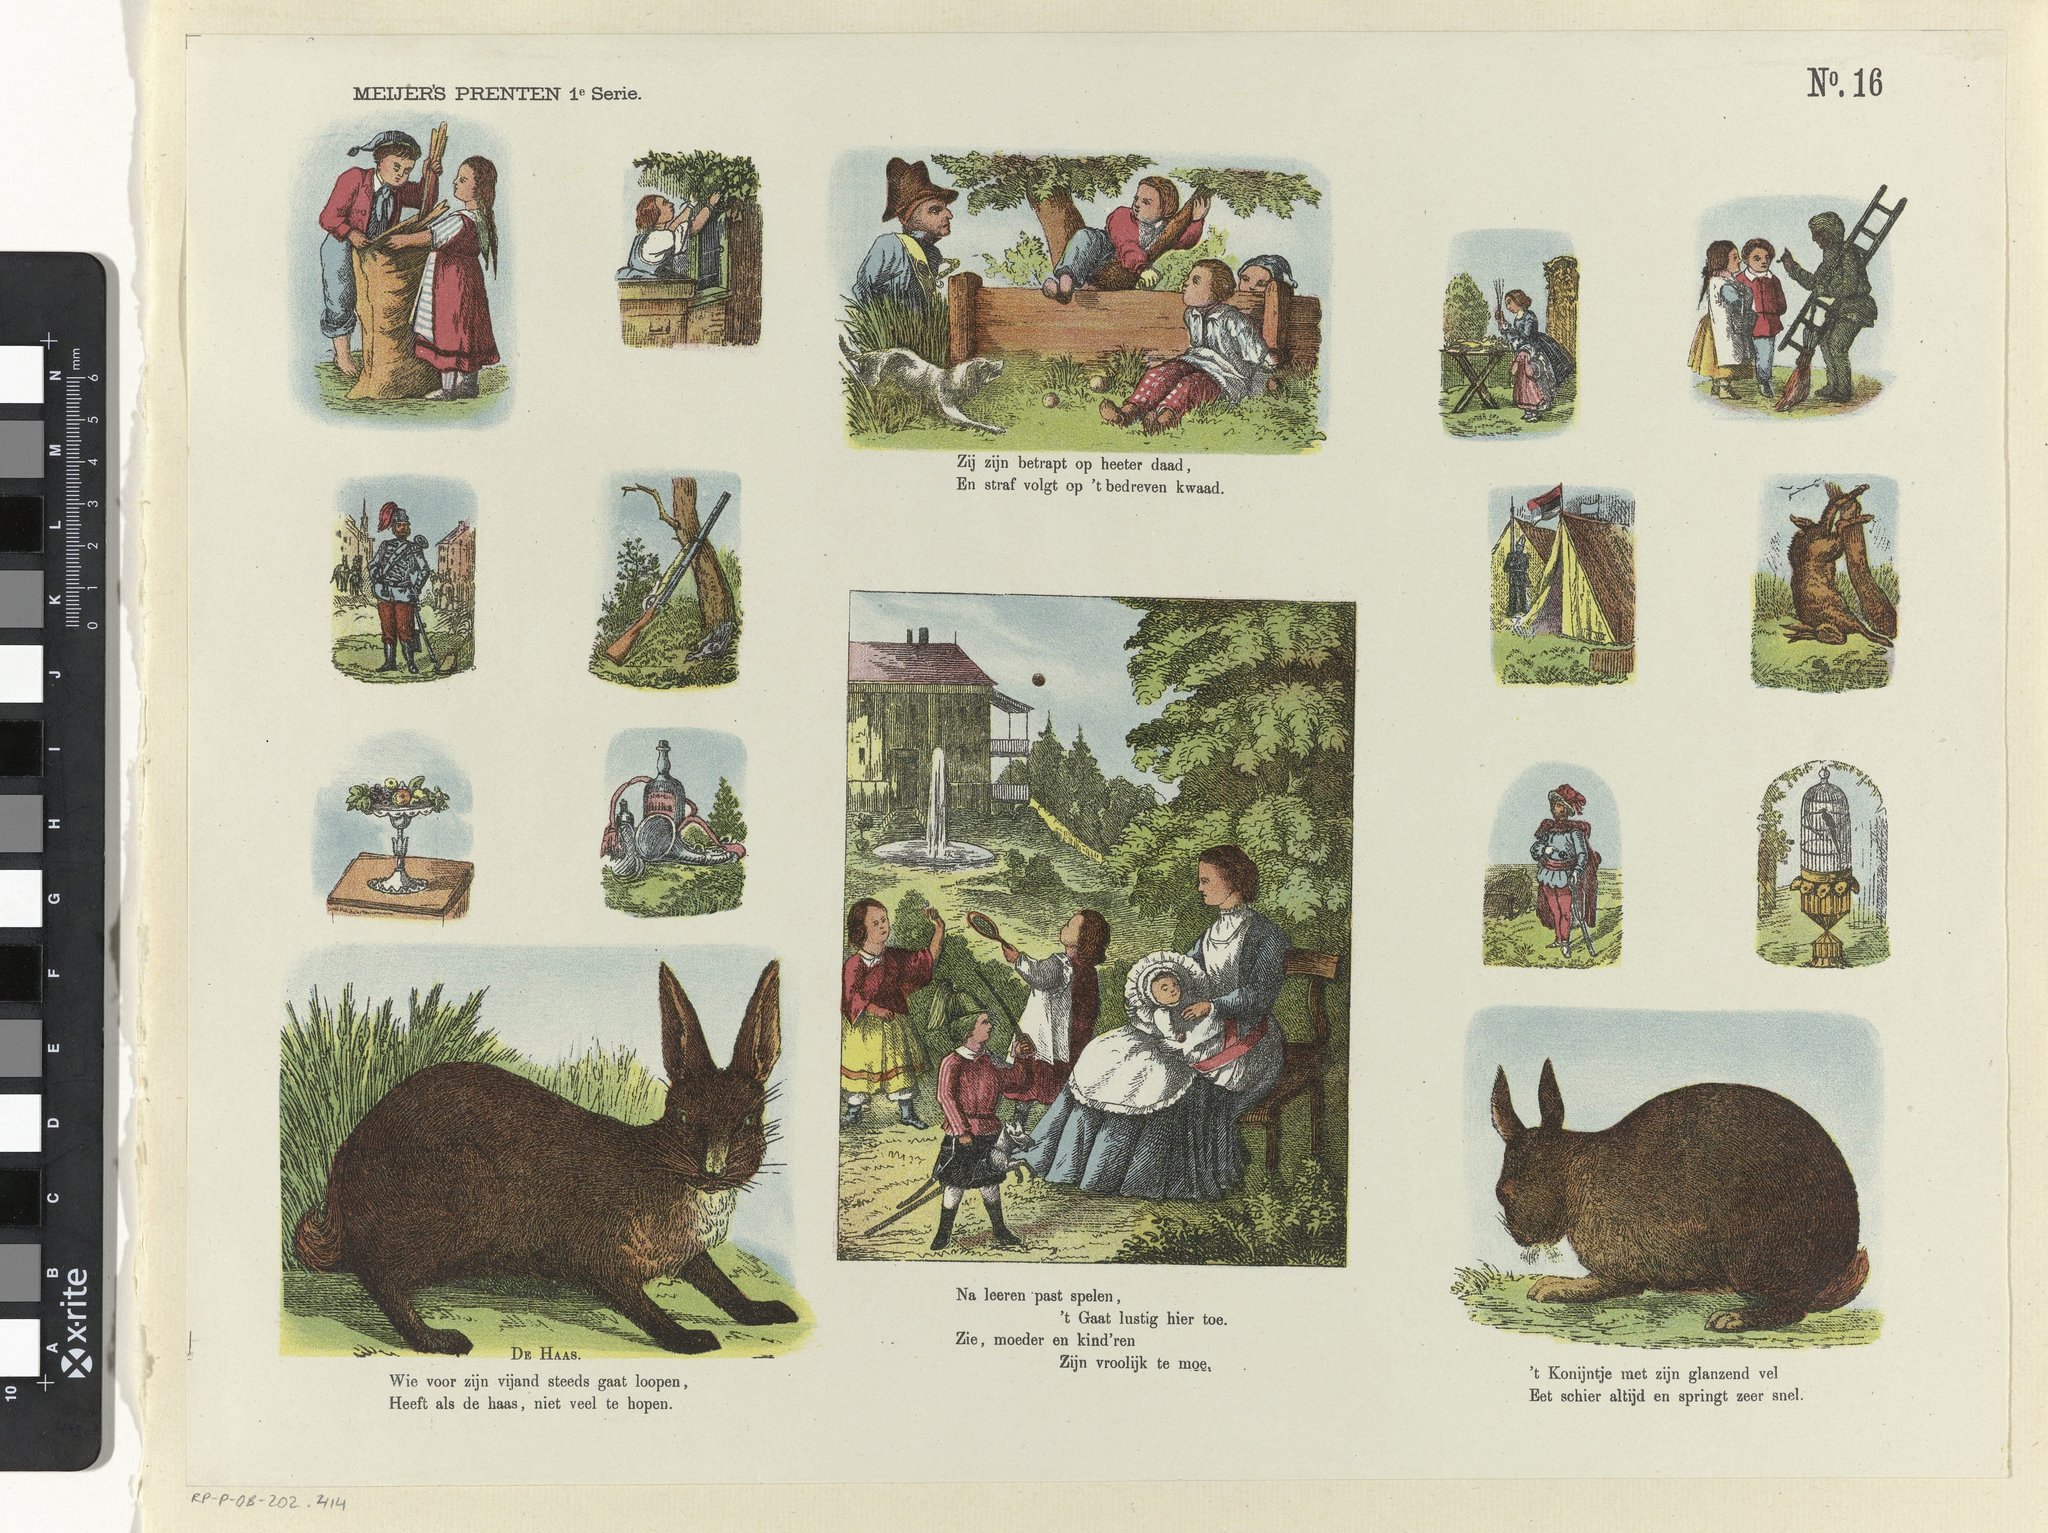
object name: print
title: Meijer's prenten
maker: Anonymous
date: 1873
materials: paper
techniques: lithograph, letterpress printing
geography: amsterdam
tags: animals, birds, handicrafts ~ maintenance and repair (with name of trade or profession), the soldier; the soldier's life, fruits: cherry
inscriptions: collector's mark: Lugt 2760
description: Blad met 16 voorstellingen van verschillende aard, waaronder voorstellingen van dieren, kinderen die hout sprokkelen, soldaten en een schoorsteenveger. Onder enkele afbeeldingen een onderschrift. Genummerd rechtsboven: No. 16.